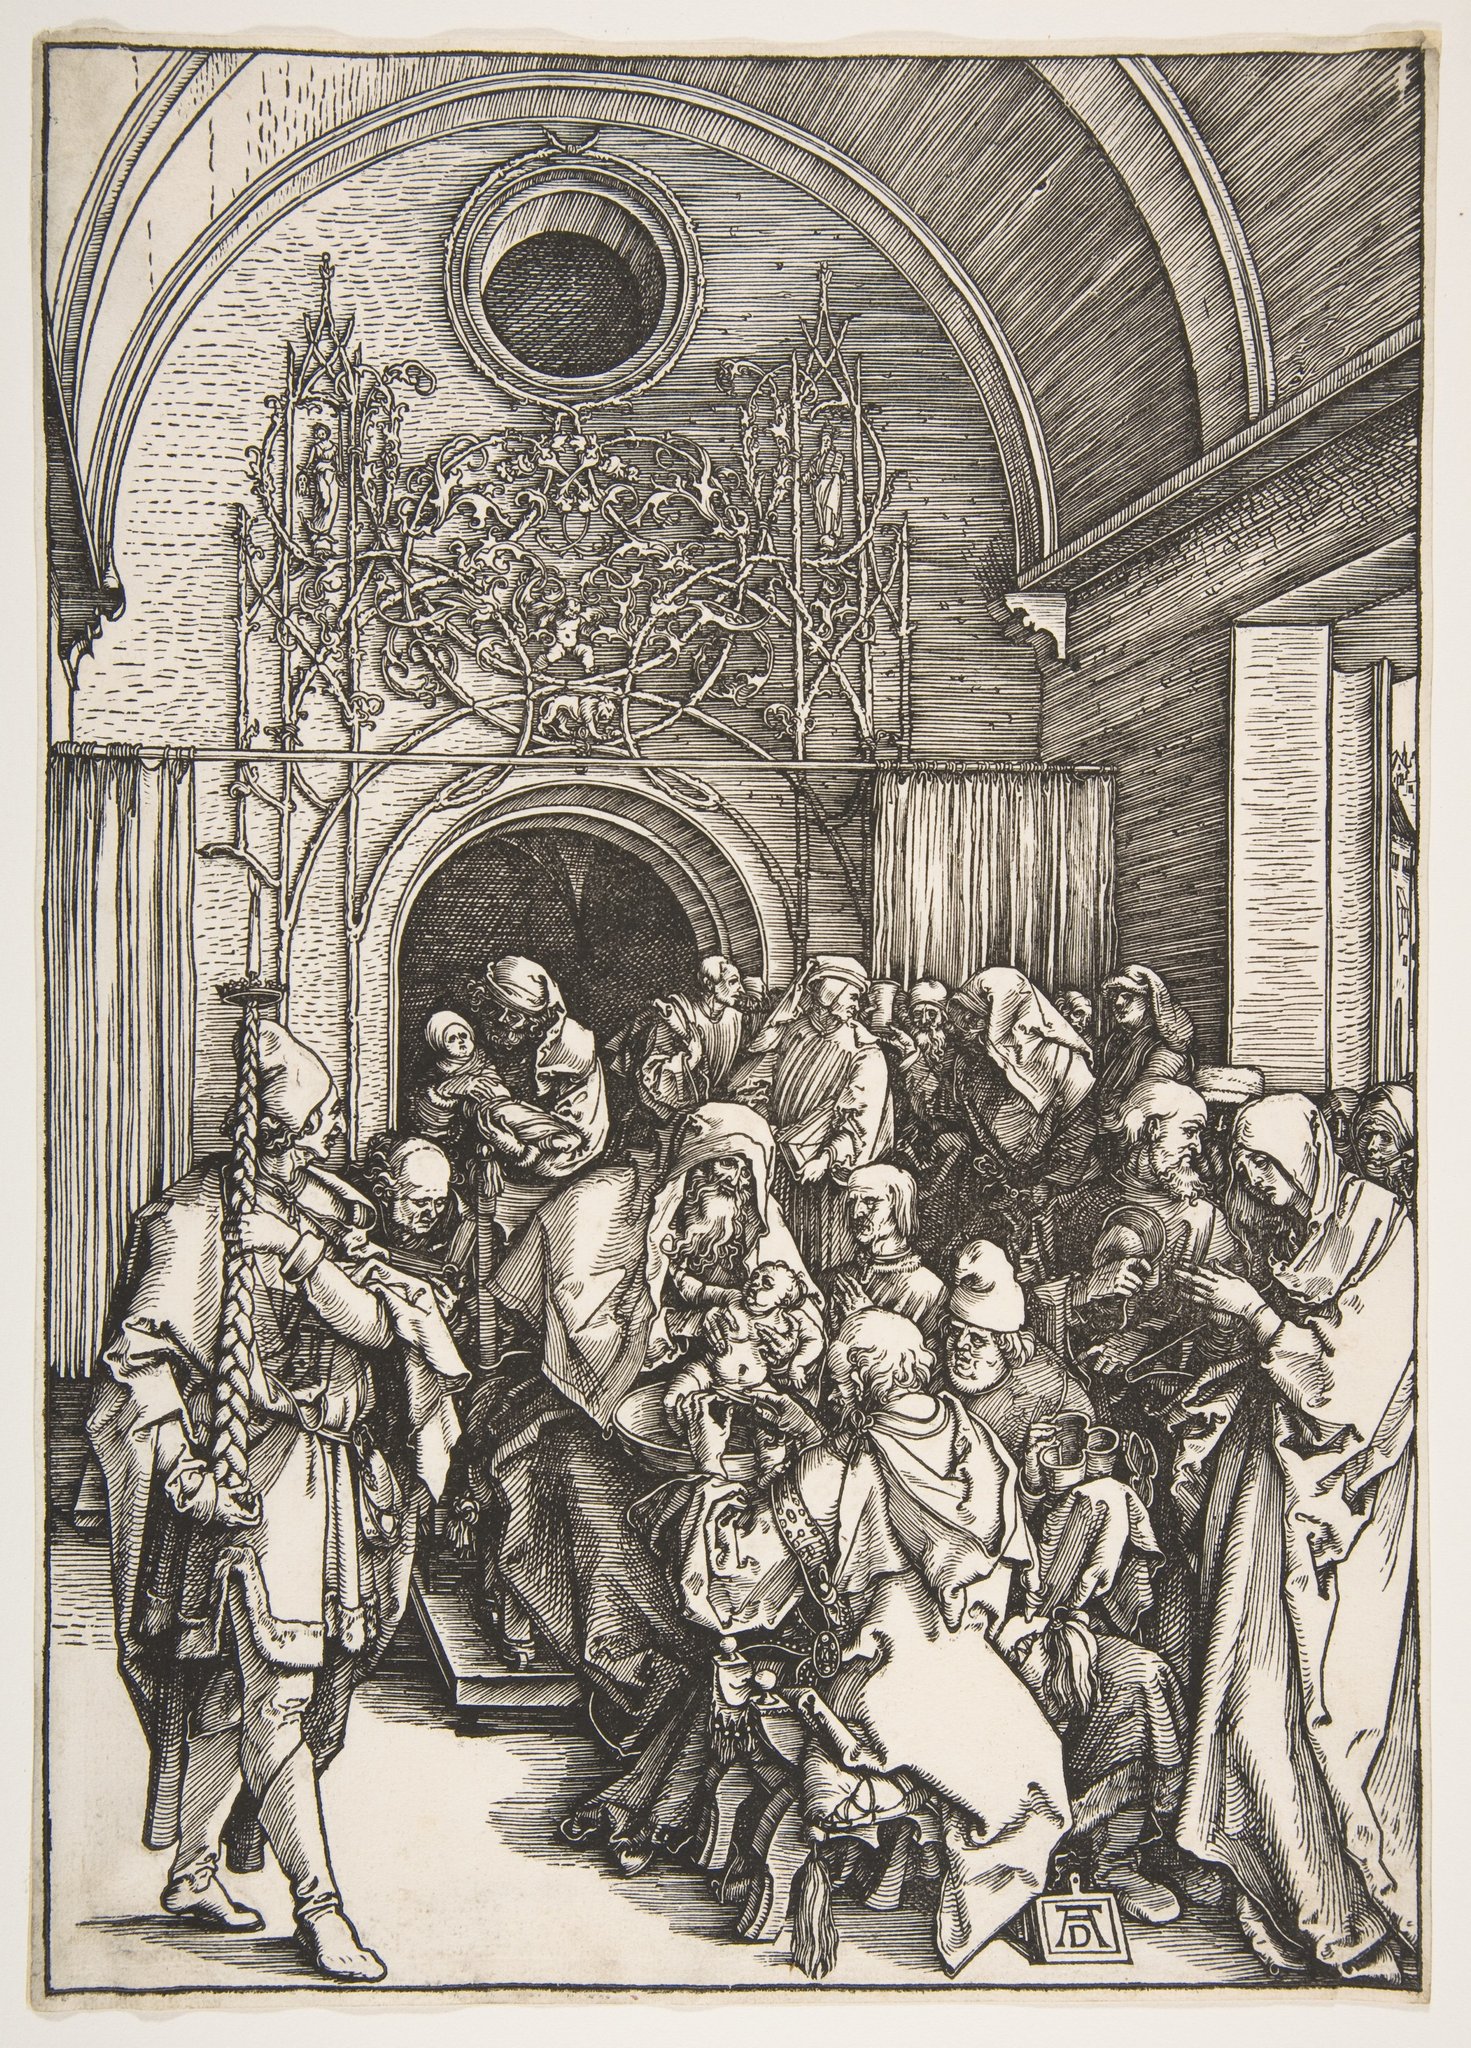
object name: print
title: The Circumcision, from "The Life of the Virgin"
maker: albrecht dürer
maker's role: artist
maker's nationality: german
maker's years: 1471-1528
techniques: woodcut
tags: men,women,virgin mary,jesus,circumcision